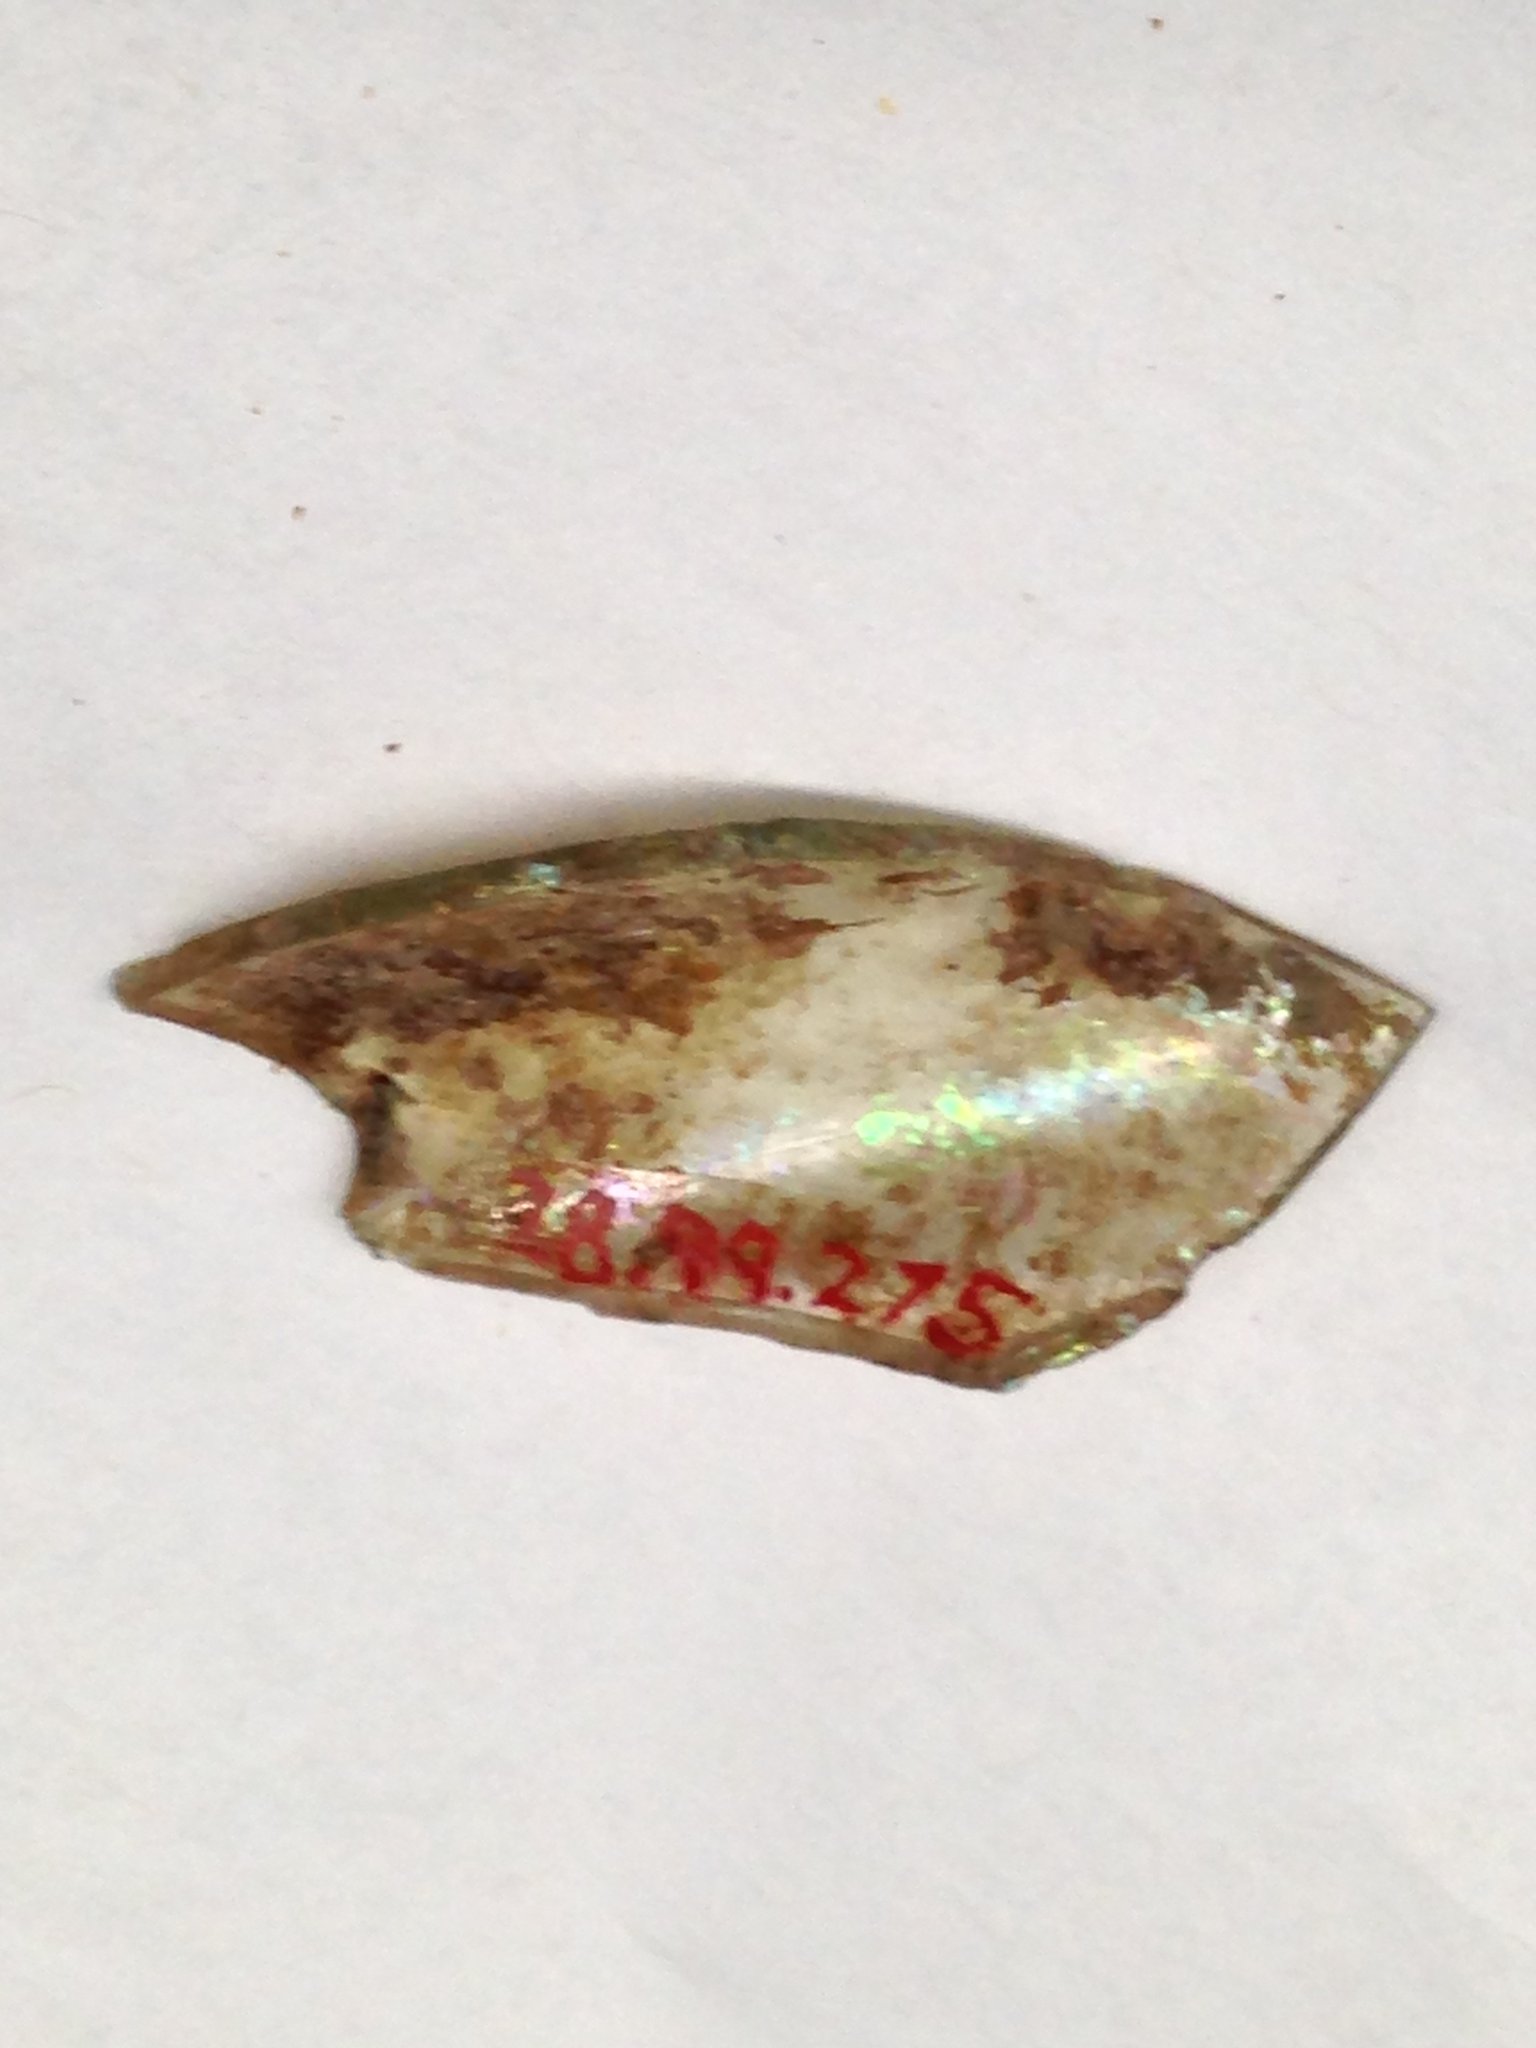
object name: fragment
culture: european or middle eastern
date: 1150-1250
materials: ceramic, glass